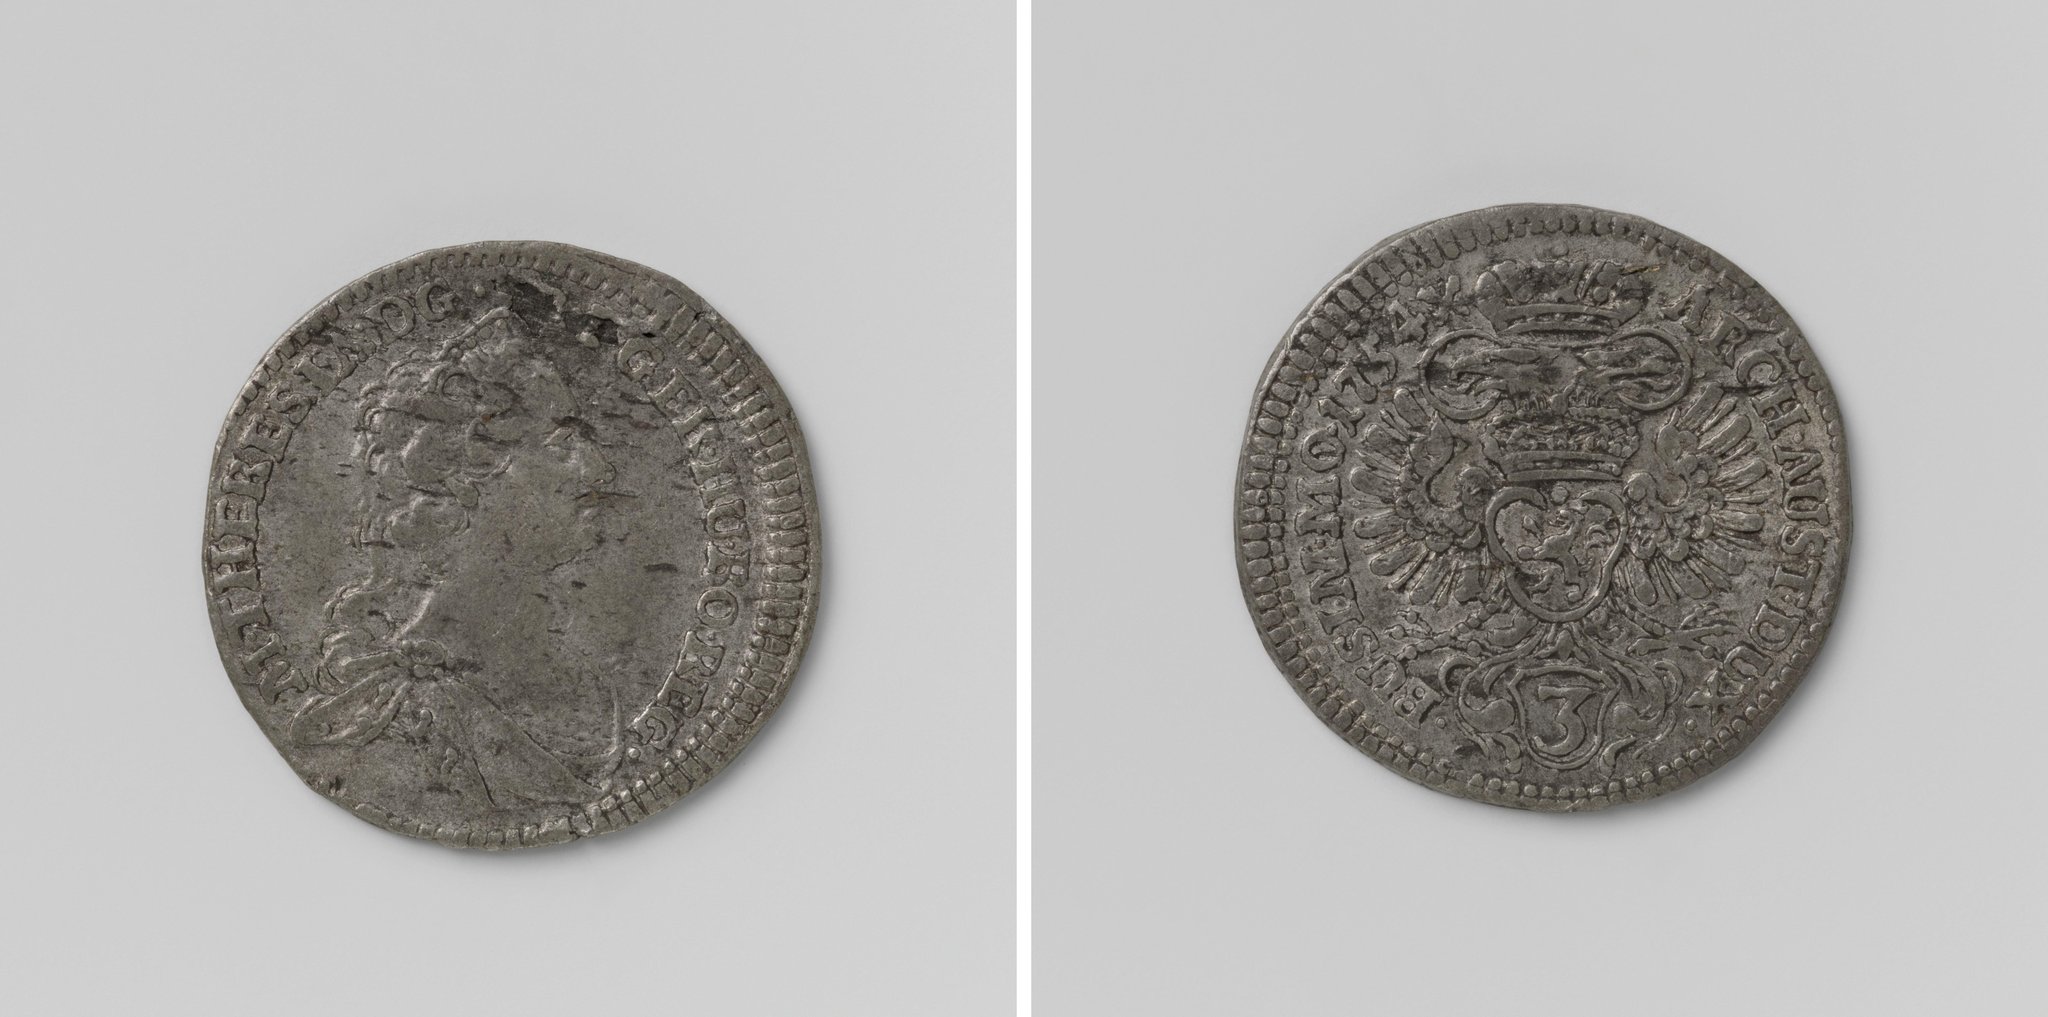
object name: coin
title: Drie kreuzer, noodmunt uit Praag op naam van Maria Theresia, gelagen tijdens het beleg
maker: Anonymous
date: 1754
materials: tin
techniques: striking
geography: prague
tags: vienna, maria theresia (rooms-duits keizerin), prague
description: Voorzijde: borststuk vrouw met diadeem naar rechts binnen omschrift. Keerzijde: gekroonde dubbelkoppige adelaar met wapenschild voor borst; daaronder: waardeaanduiding in cartouche binnen omschrift